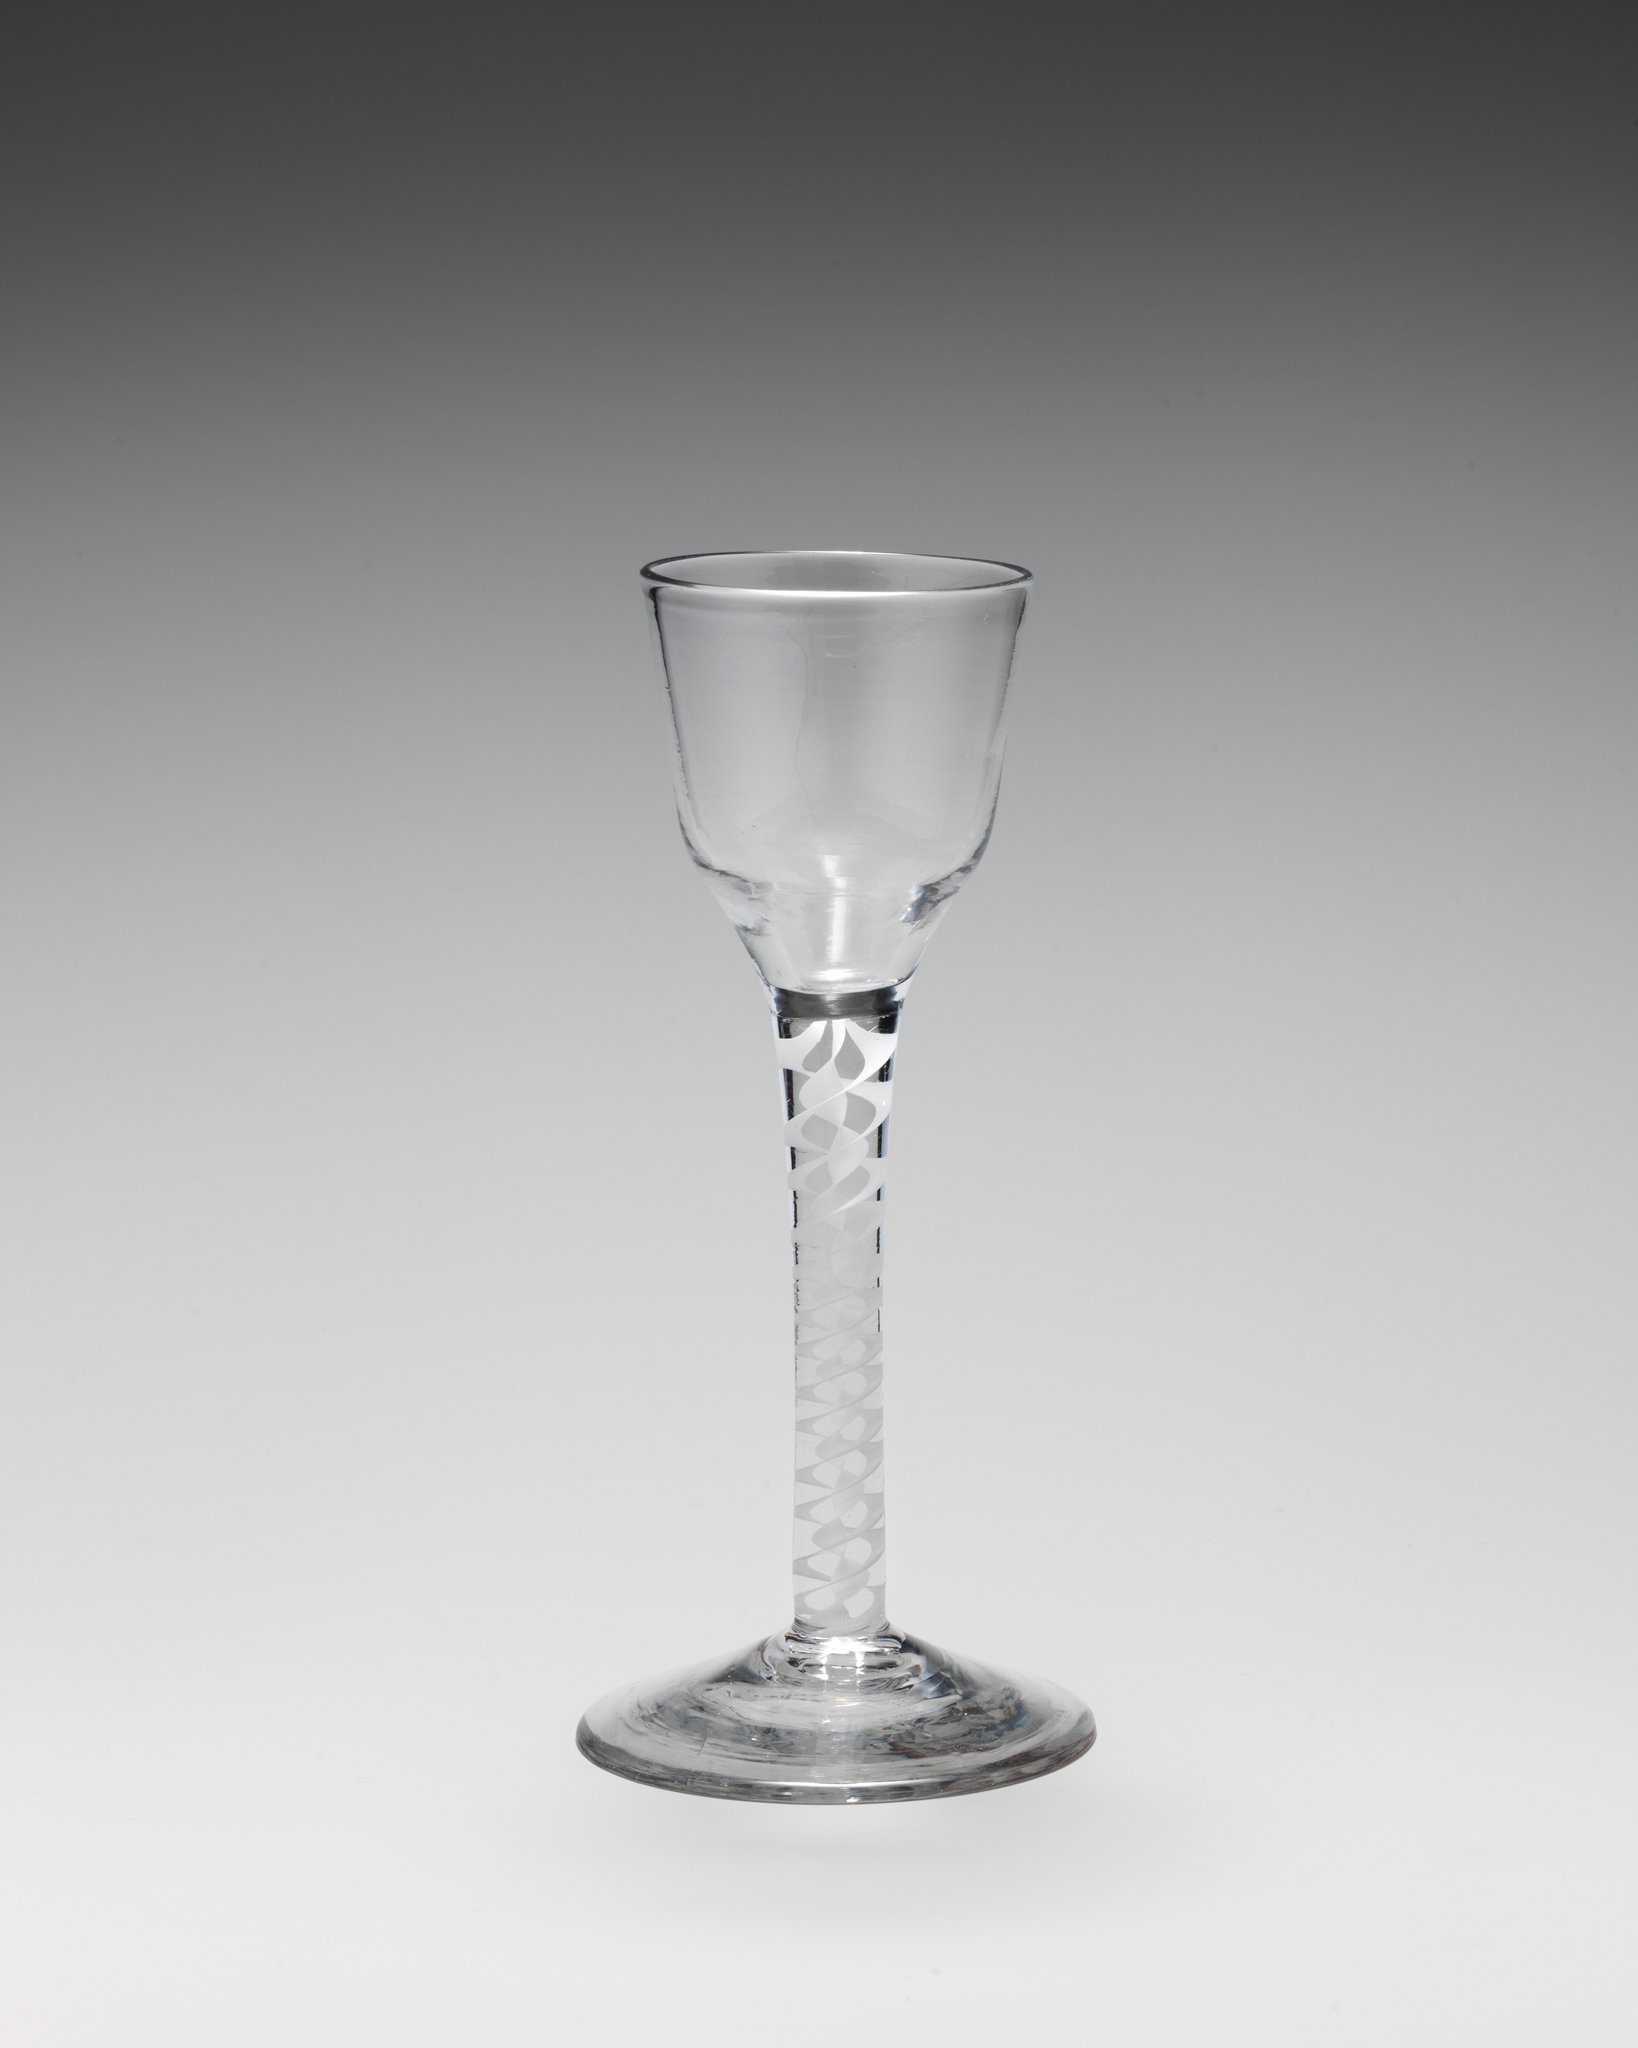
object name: wineglass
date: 1750-1800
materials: glass